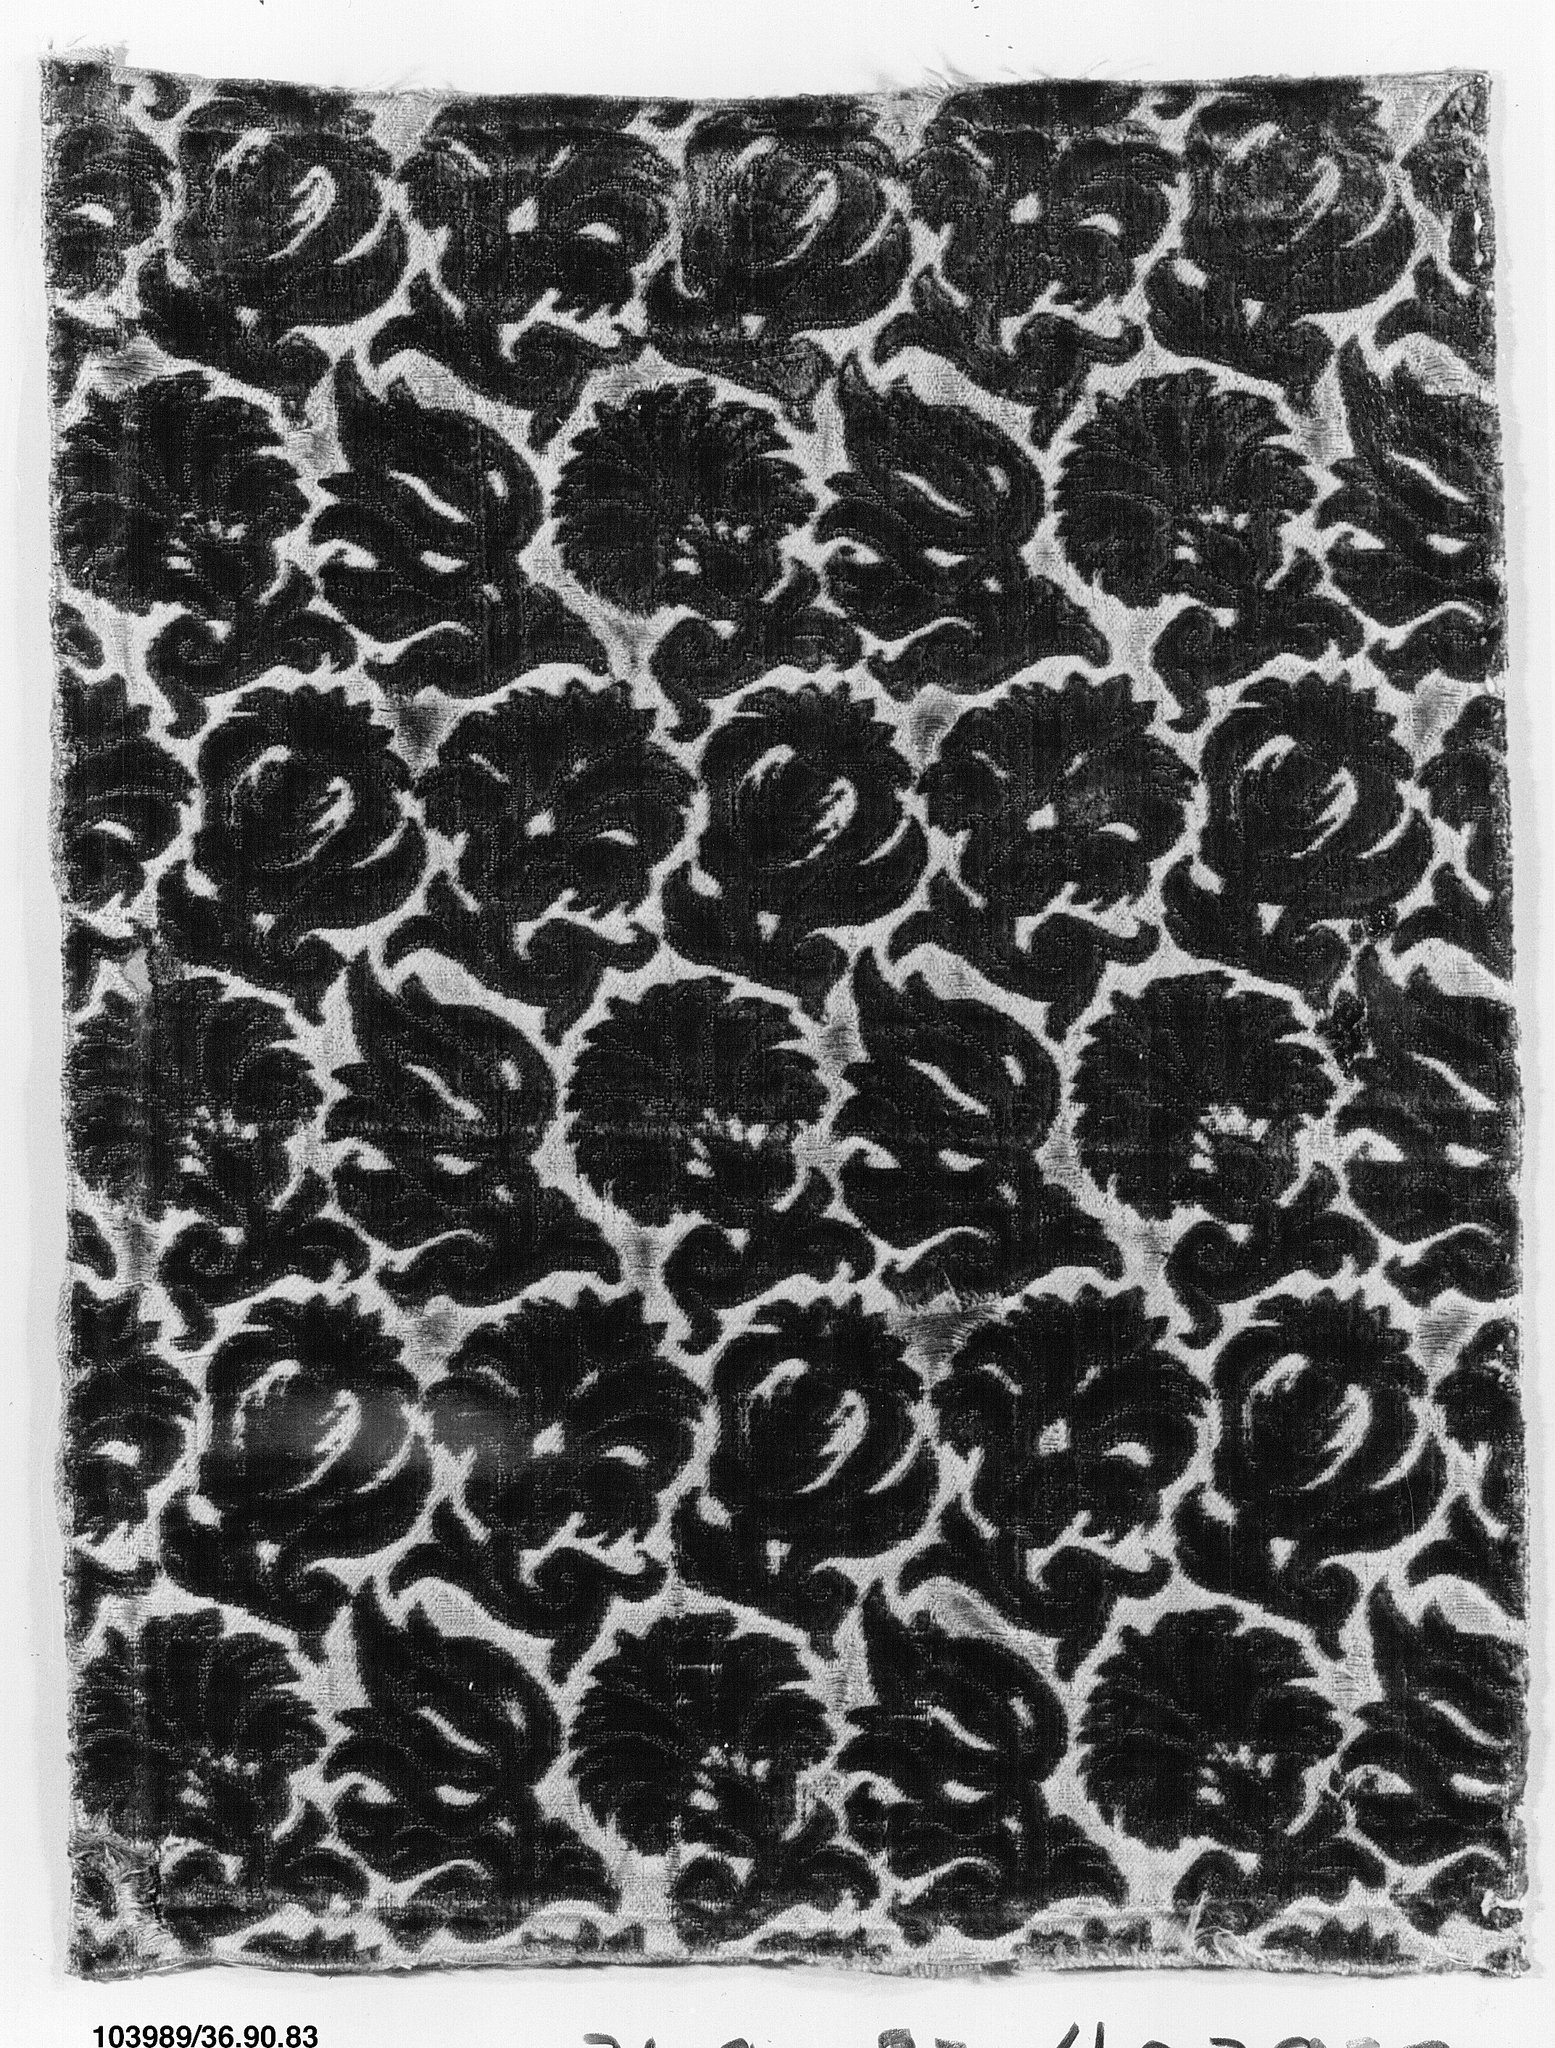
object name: piece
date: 1501-1700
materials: silk